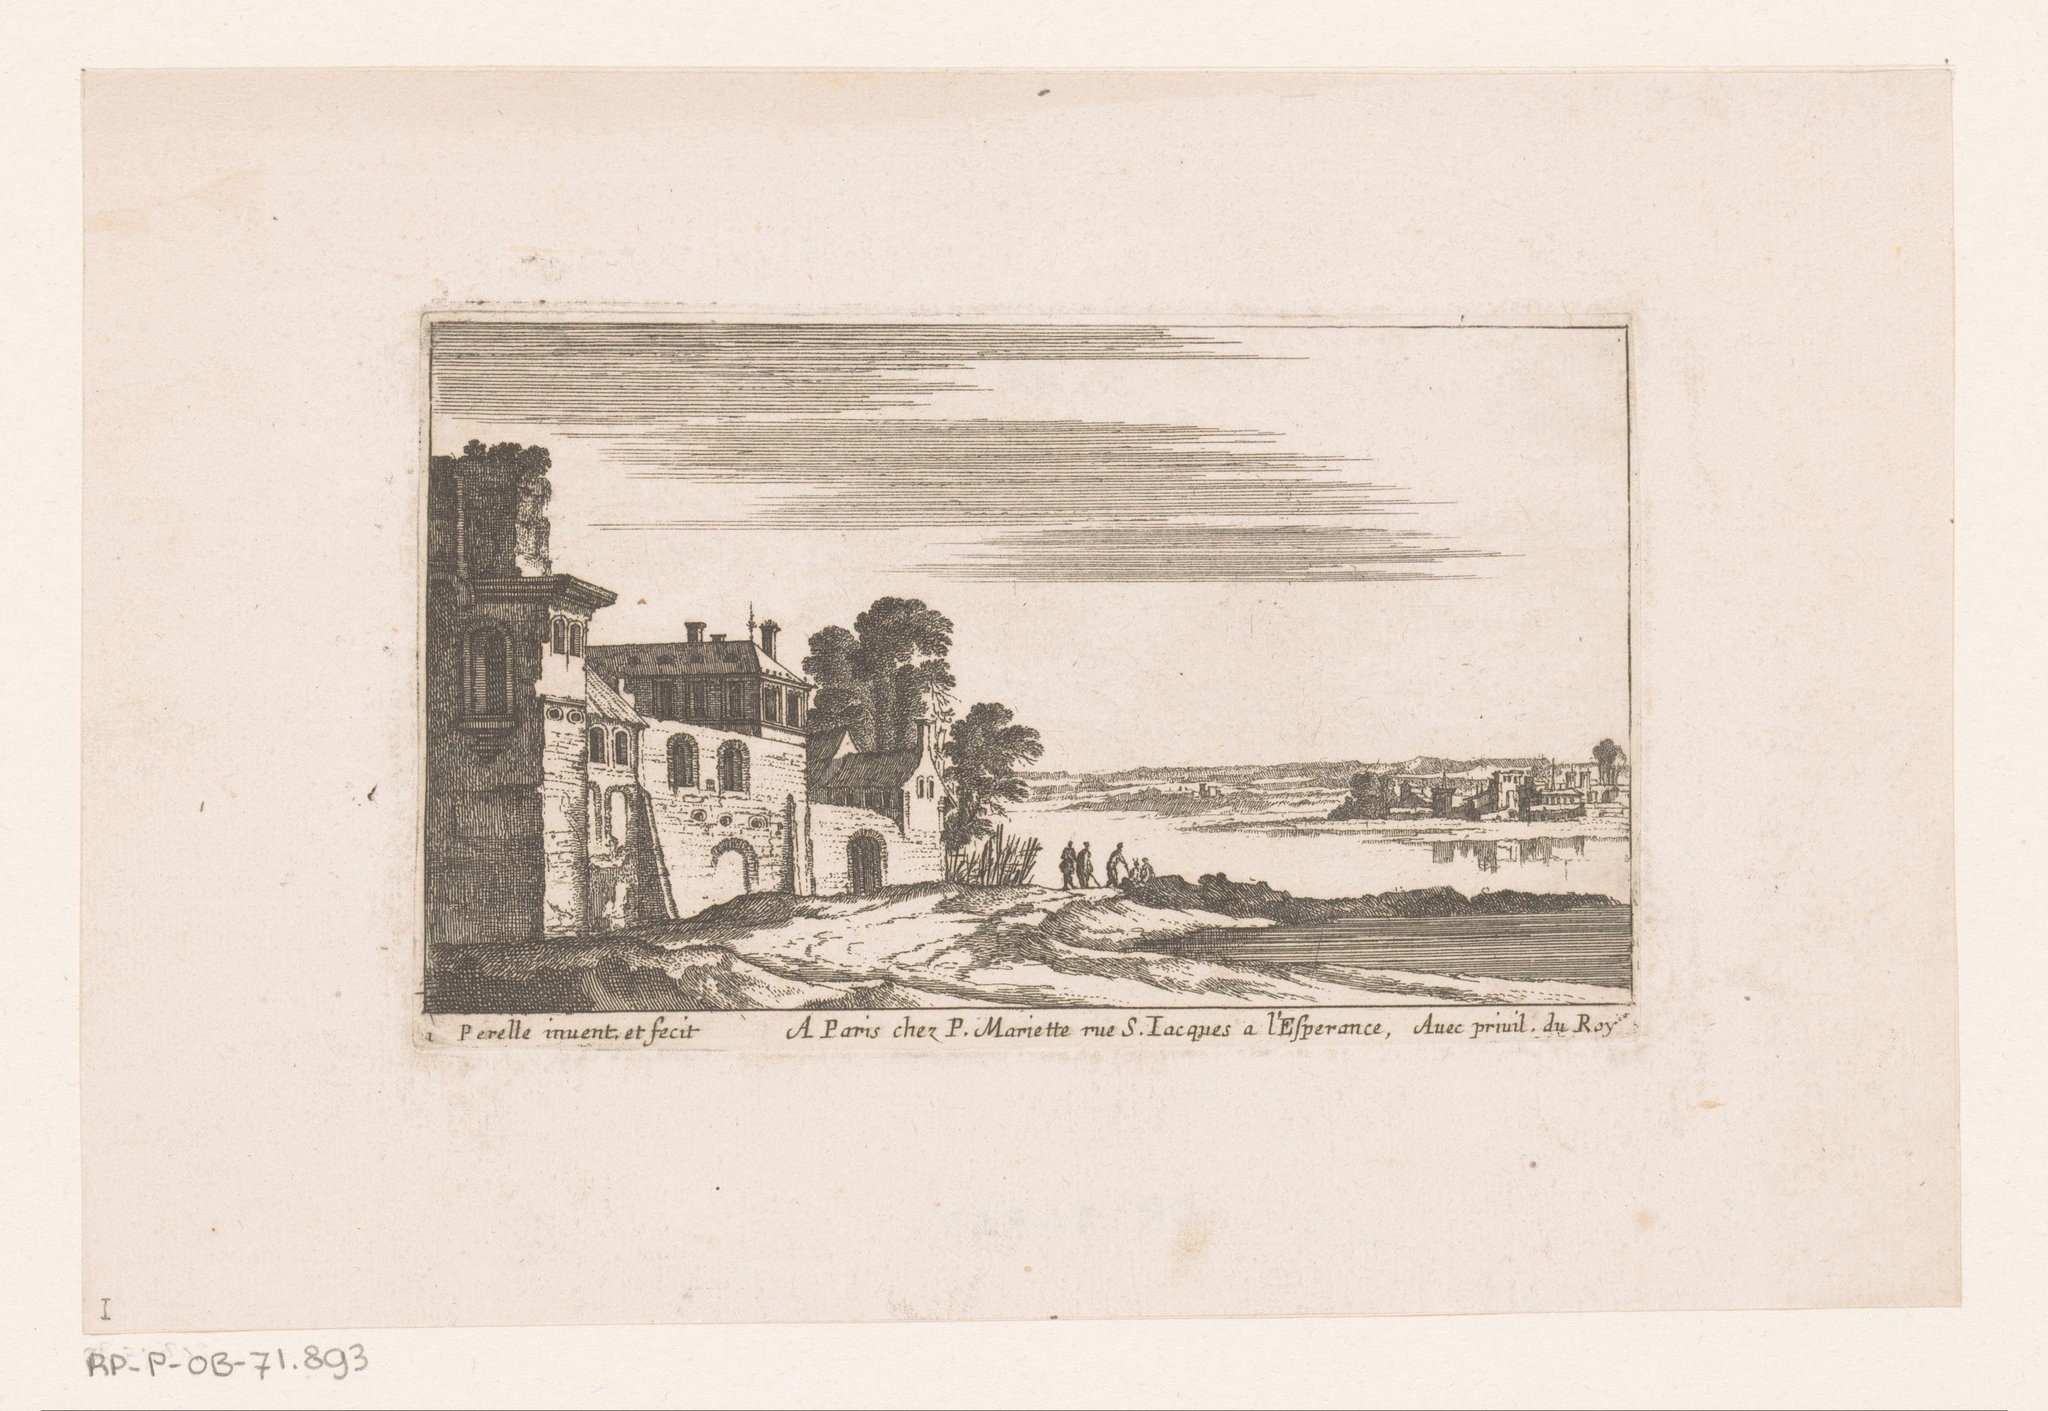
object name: print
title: Landschap met gebouwen bij rivier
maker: mariette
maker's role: publisher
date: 1613-1695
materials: paper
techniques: etching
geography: france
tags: landscapes with waters, waterscapes, seascapes (in the temperate zone)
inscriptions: collector's mark: Lugt 240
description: Prenten met het signatuur 'Perelle' kunnen zowel door vader Gabriel als door zonen Nicolas en Adam gemaakt zijn.